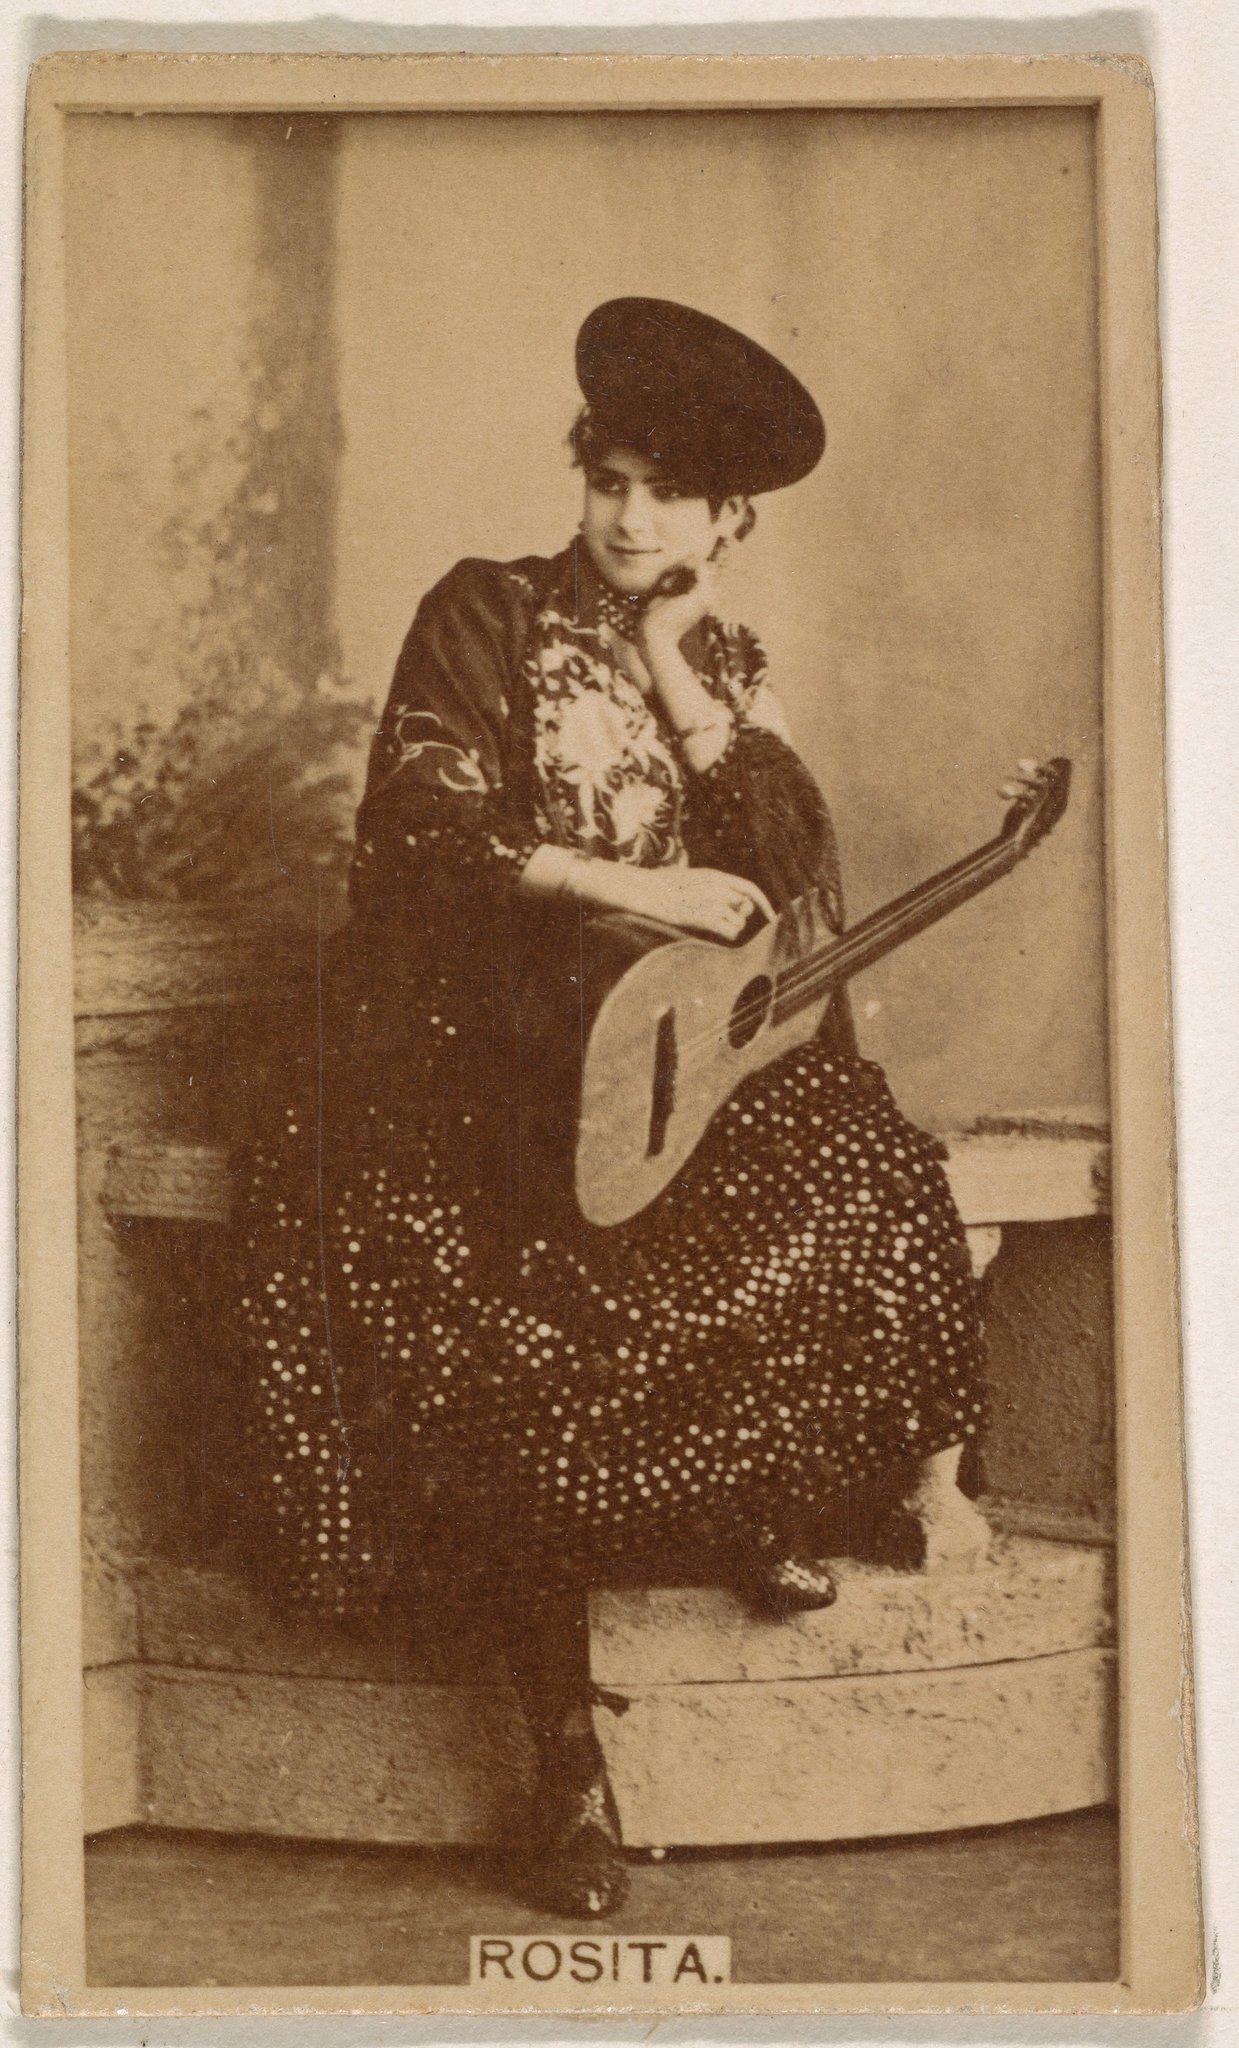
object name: photograph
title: Rosita, from the Actresses series (N245) issued by Kinney Brothers to promote Sweet Caporal Cigarettes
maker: kinney brothers tobacco company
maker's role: publisher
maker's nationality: american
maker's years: 1869-2011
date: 1890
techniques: albumen silver print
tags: portraits,women,guitars,actresses